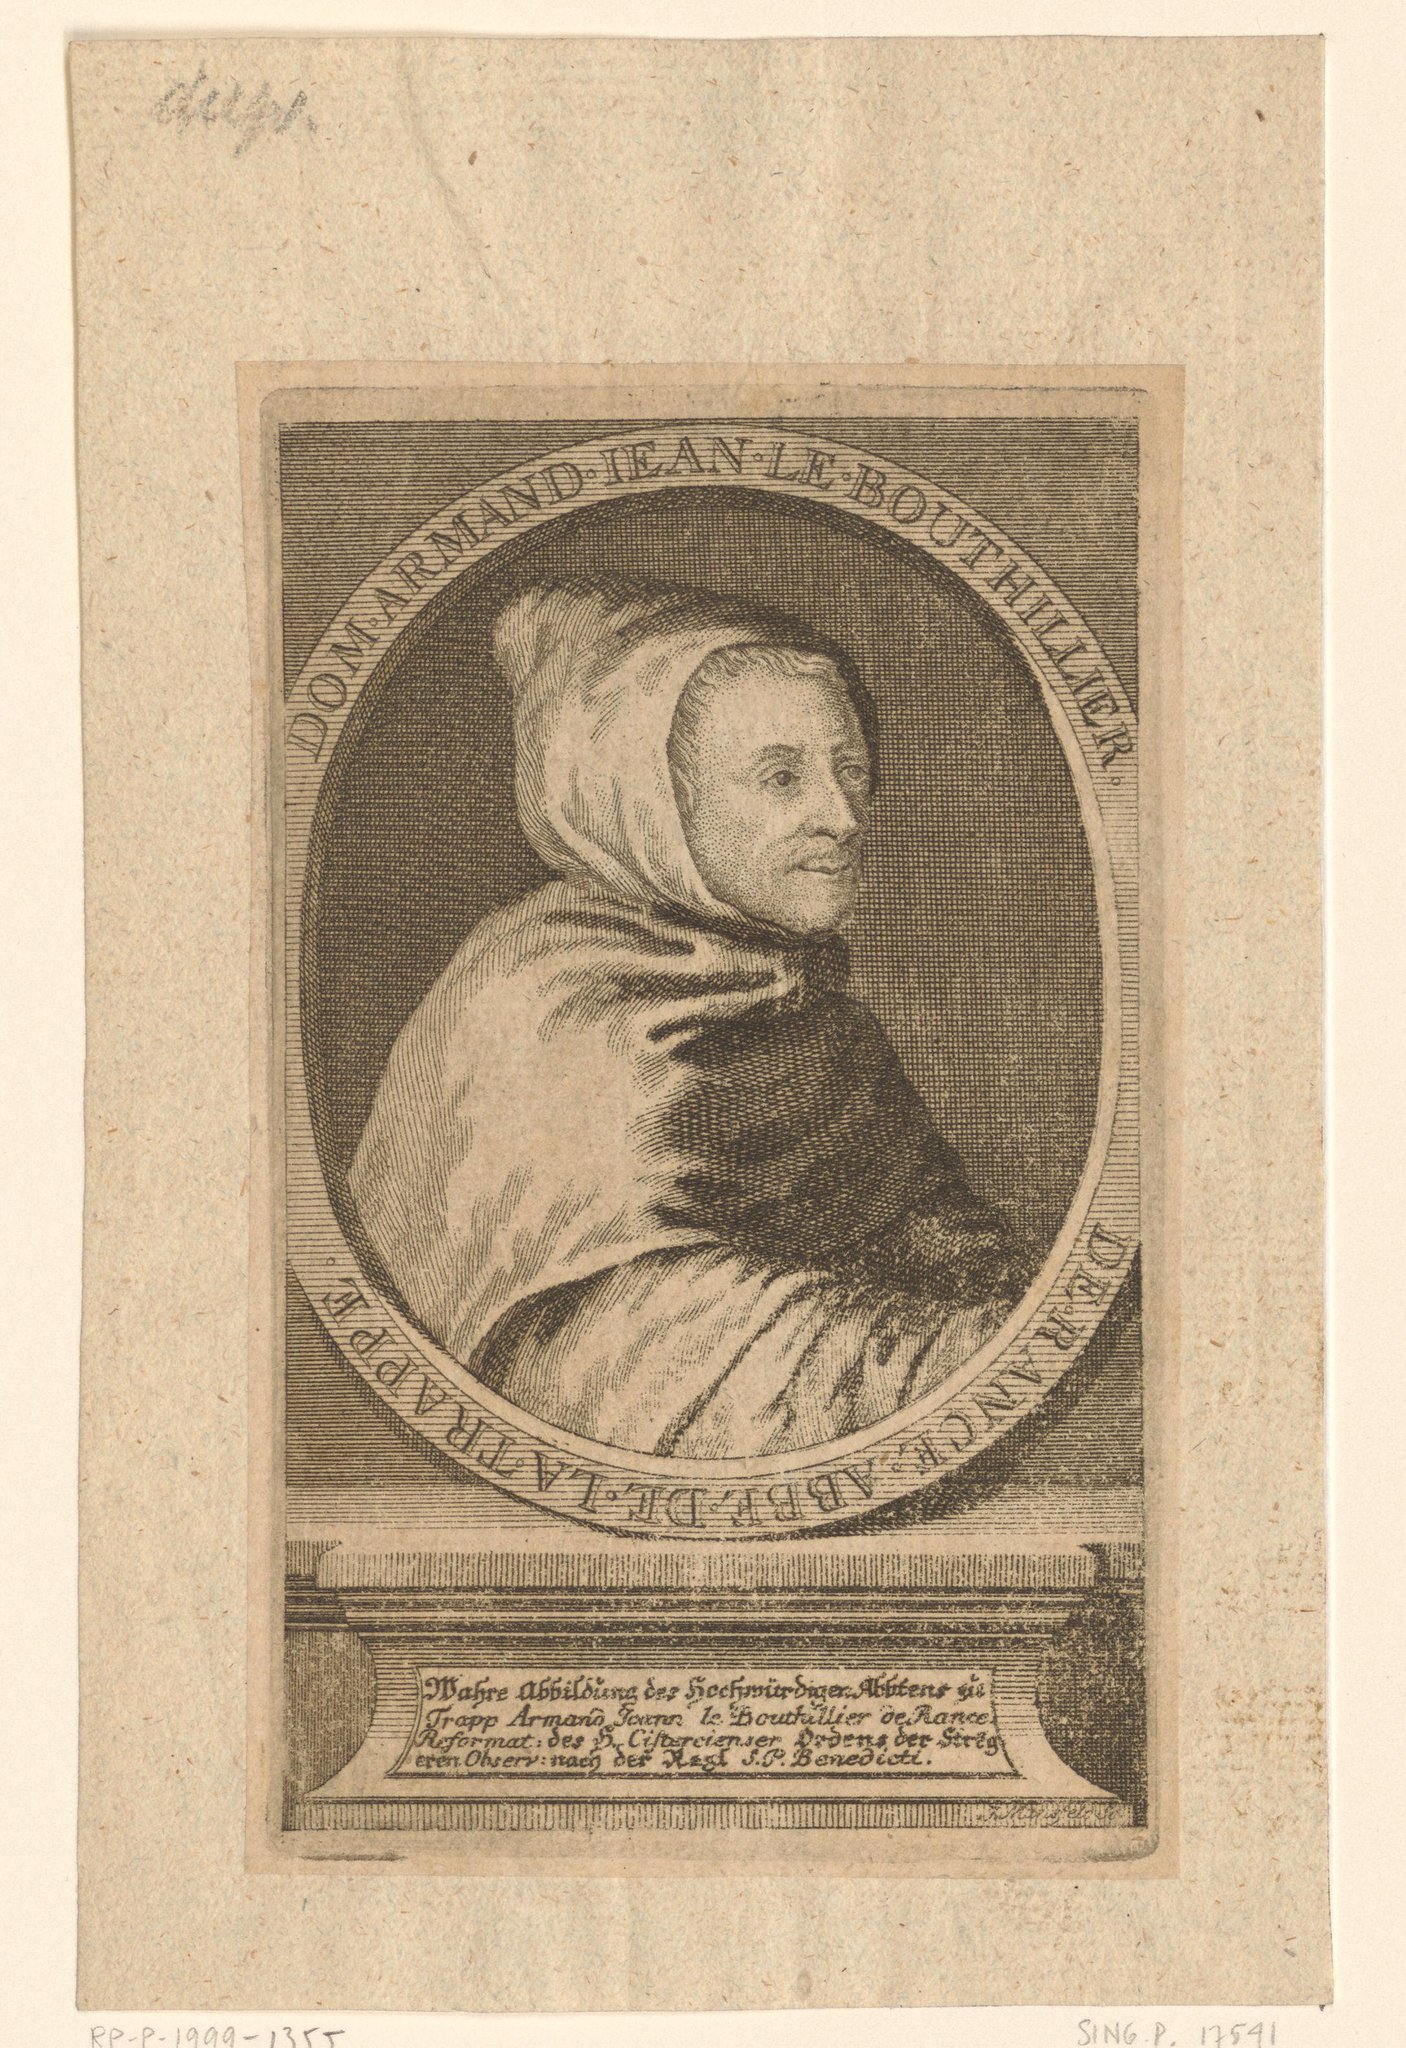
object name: print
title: Portret van Armand Jean Le Bouthillier de Rancé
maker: johann ernst mansfeld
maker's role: print maker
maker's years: 1739-1796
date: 1749-1796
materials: paper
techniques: engraving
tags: paris, priest, historical persons, monk(s), friar(s)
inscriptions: collector's mark: Lugt 2228, collector's mark: Lugt 2760